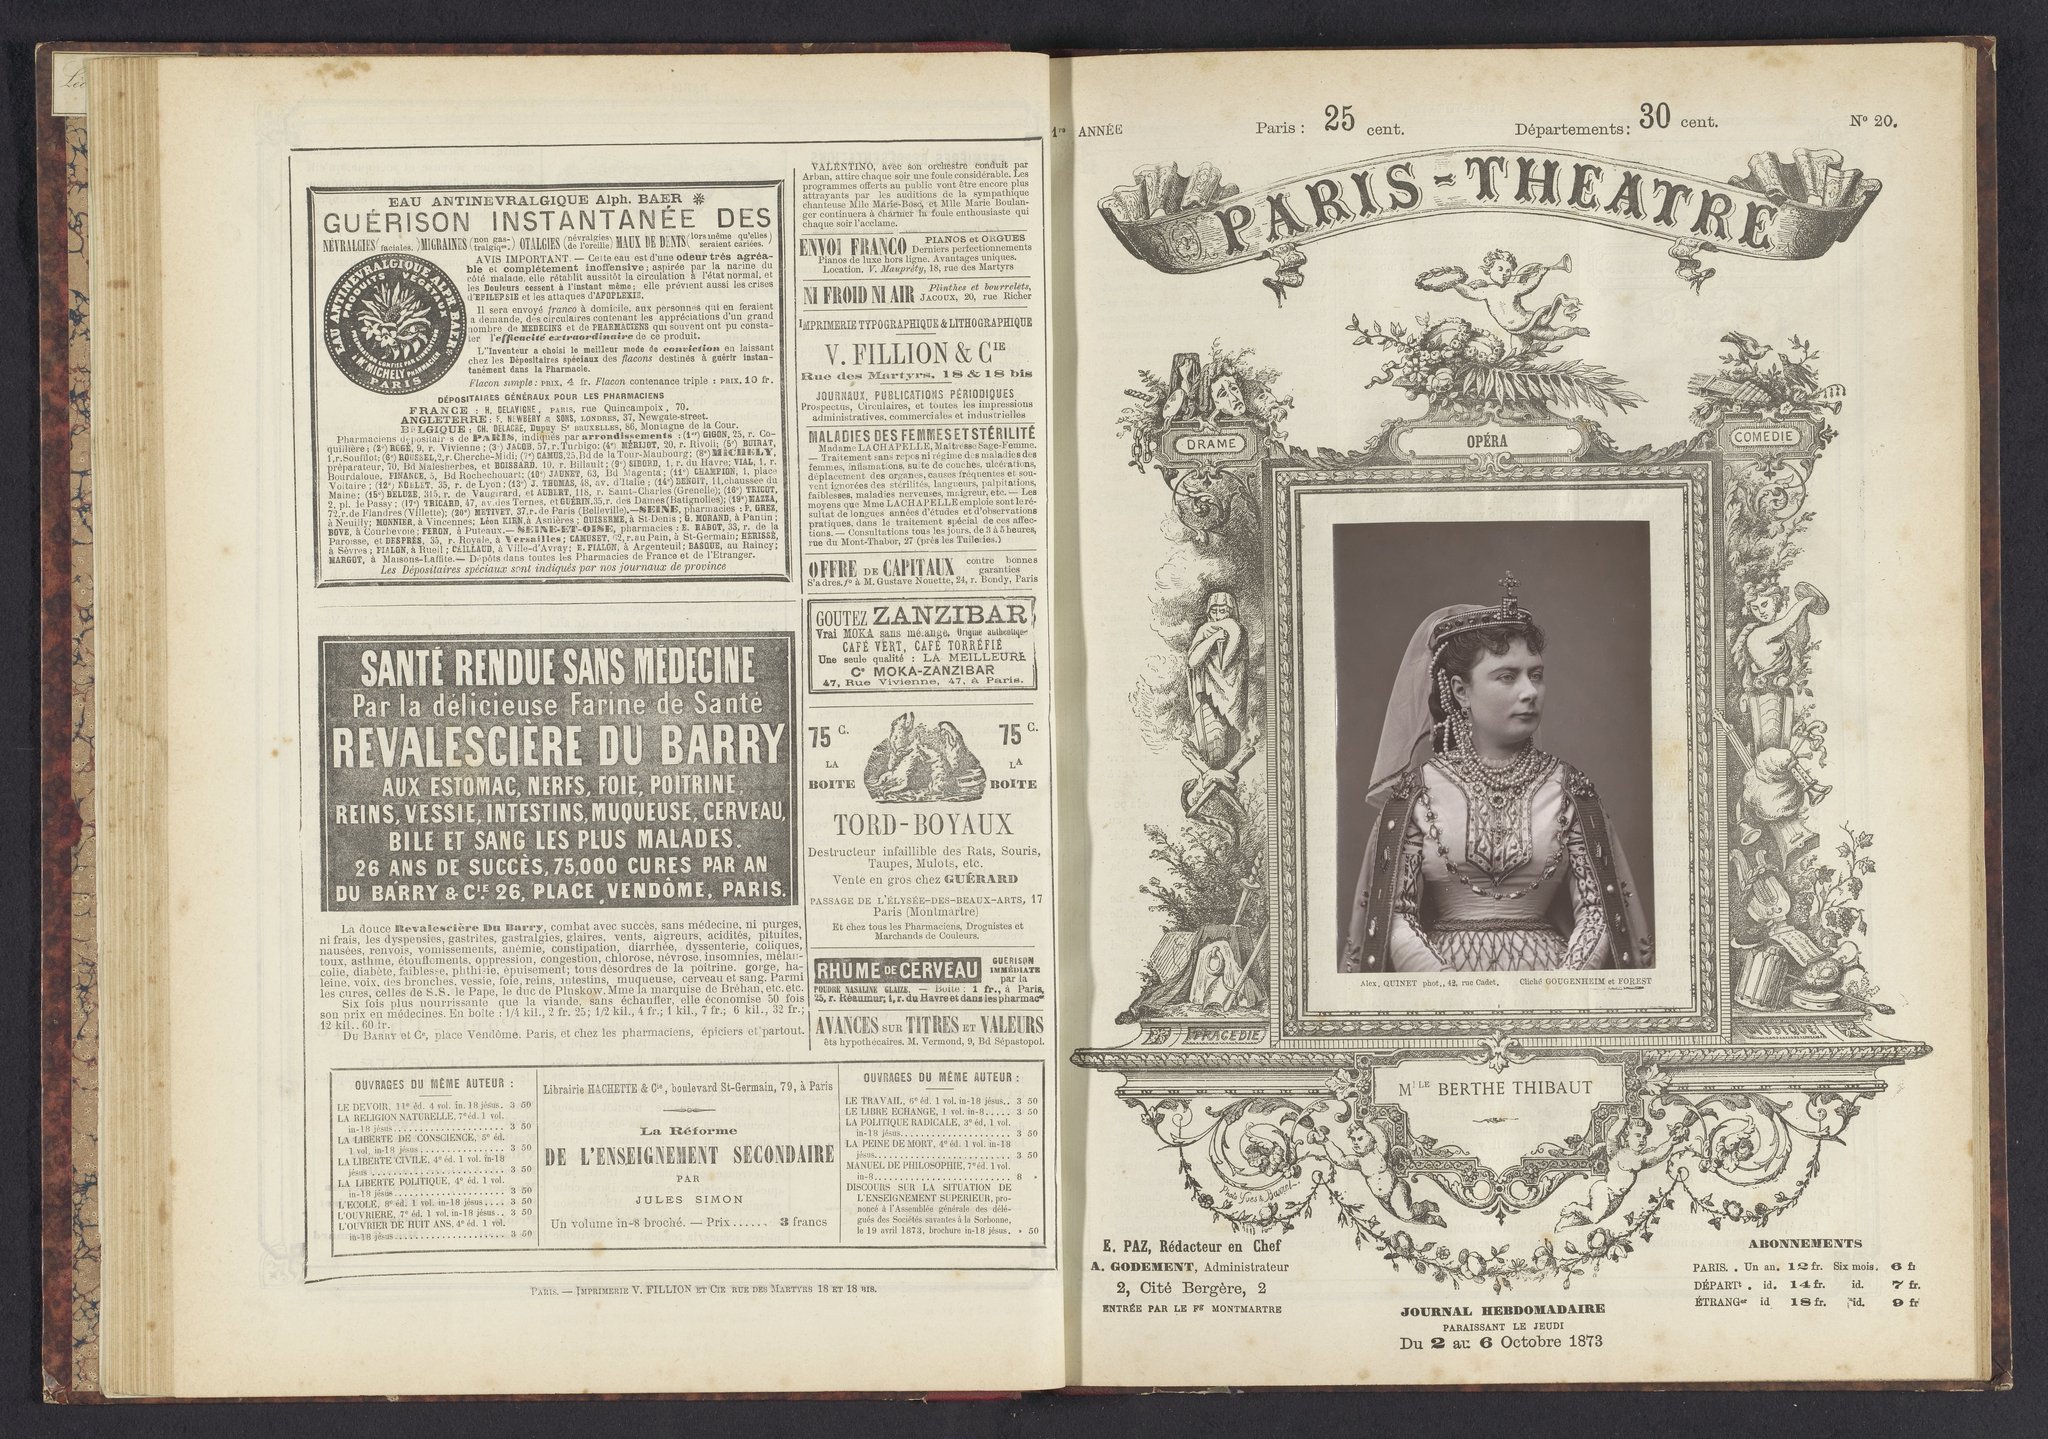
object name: page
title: Portret van Berthe Thibaut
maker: alexandre quinet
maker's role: fotograaf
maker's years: 1837-1900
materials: paper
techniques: woodburytype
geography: france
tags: portrait of opera-singer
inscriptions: inscription: ‘Journal hebdomadaire paraissant le jeudi Du 2 au 6 Octobre 1873’, number: ‘No 20.’, name: ‘Alex. Quinet, phot., rue Cadet.’